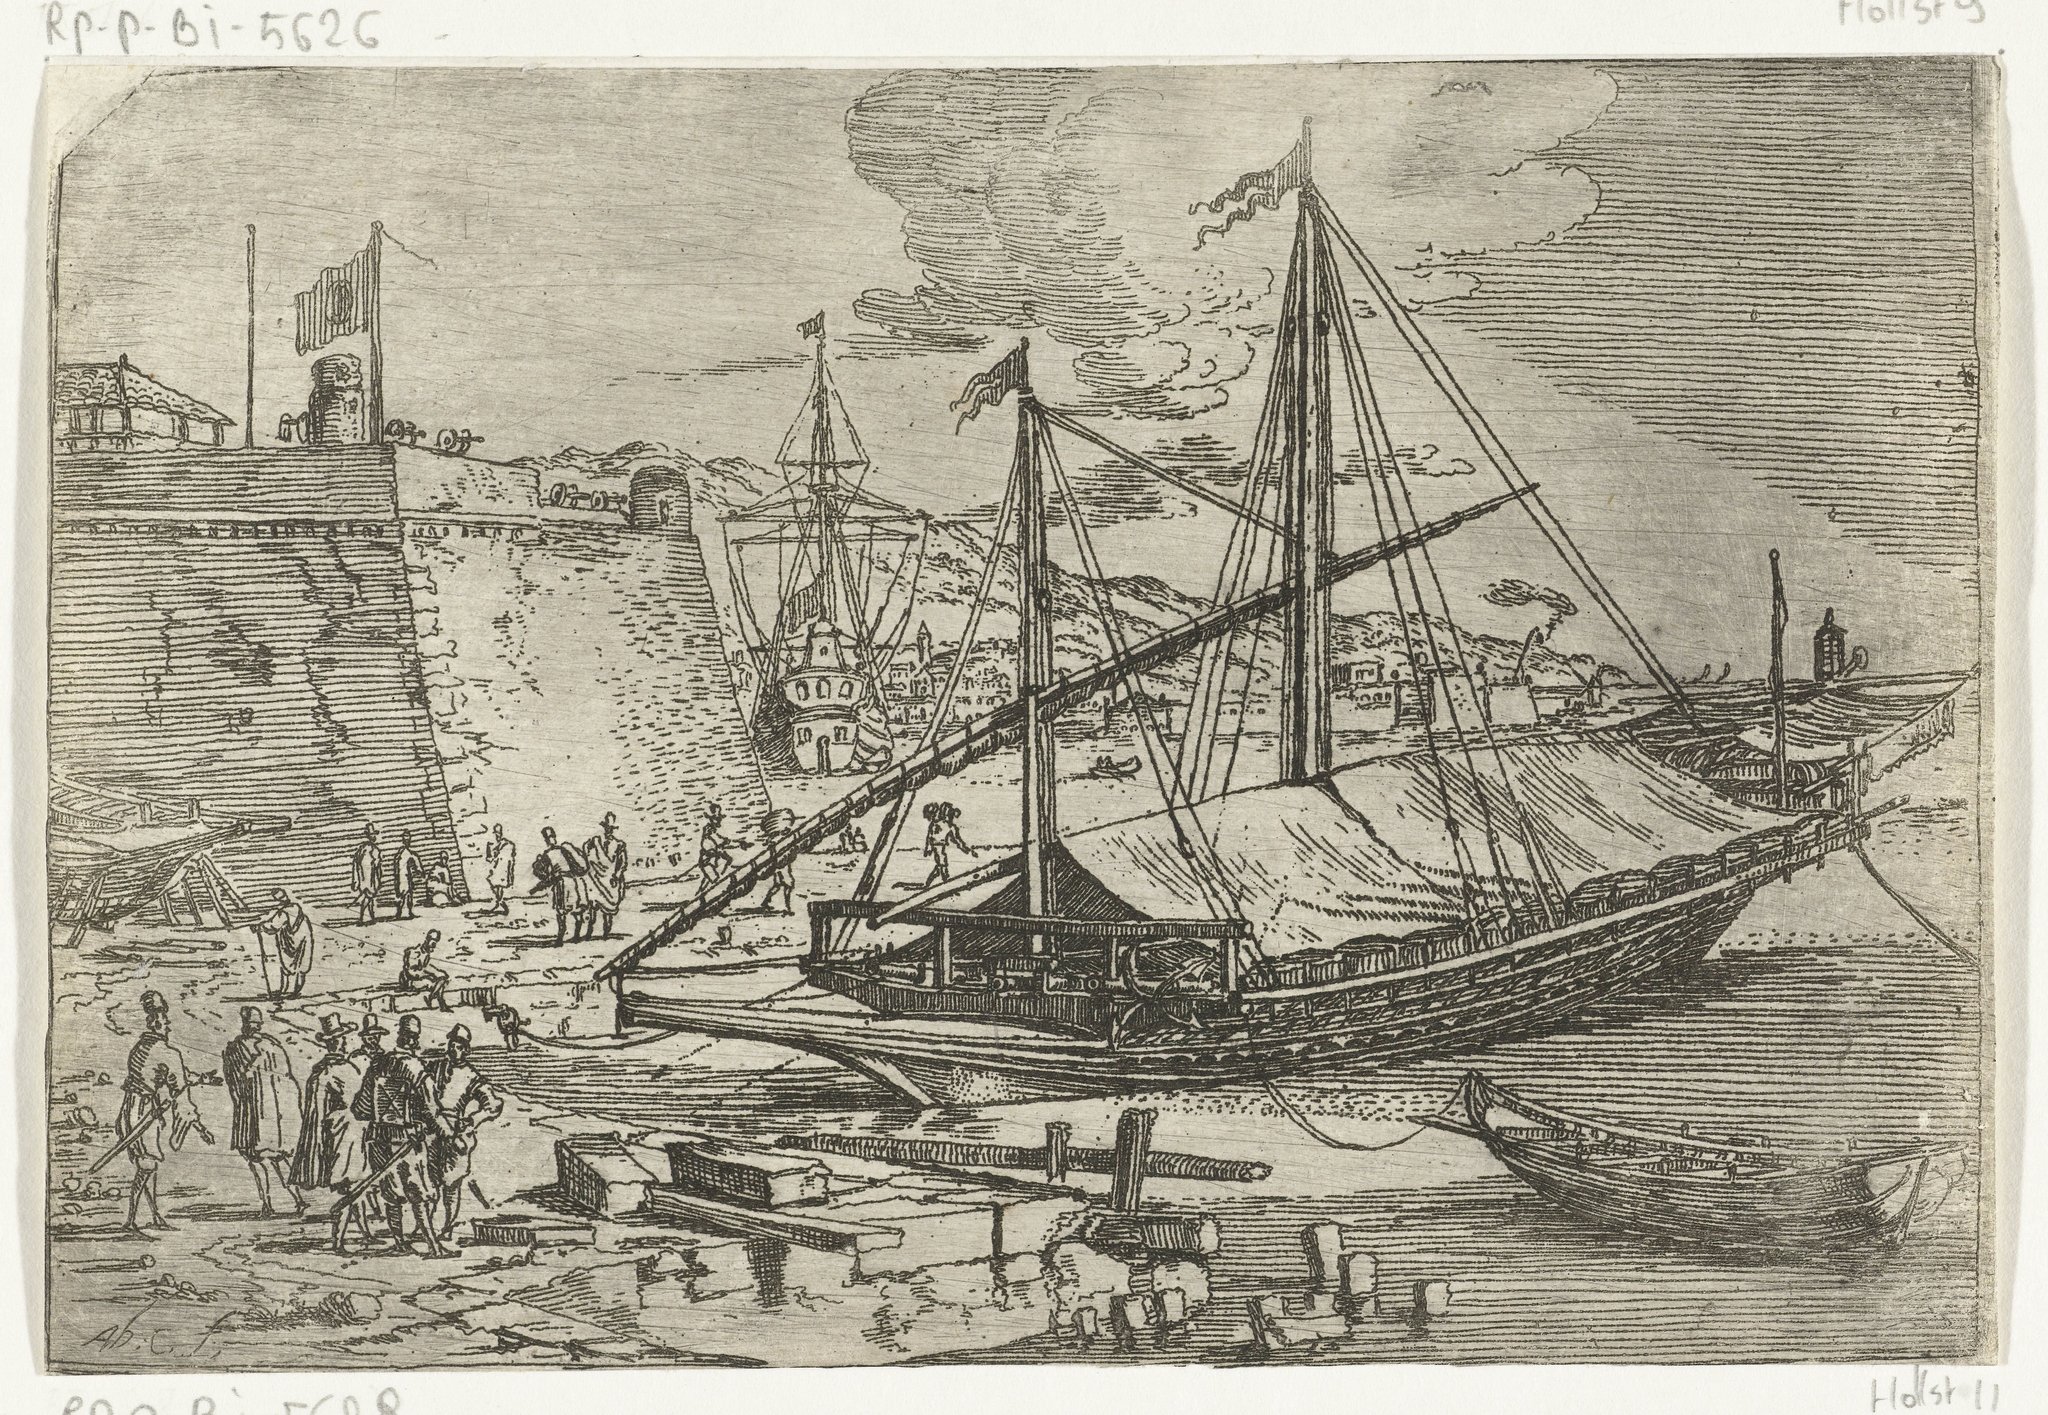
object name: print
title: Gezichten van de haven van Messina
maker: abraham de casembroot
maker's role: draughtsman, print maker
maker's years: 1573-1658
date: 1603-1658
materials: paper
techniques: etching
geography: southern netherlands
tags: harbour, fortress, warfare; military affairs (+ oared ships, e.g.: galley), quay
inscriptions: collector's mark: Lugt 2166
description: Gezicht op het zeefort van de haven van Messina. Op de voorgrond ligt een galei voor anker. Op de kade is er heel wat bezigheid. Prent uit serie van dertien prenten met gezichten van de haven van Messina